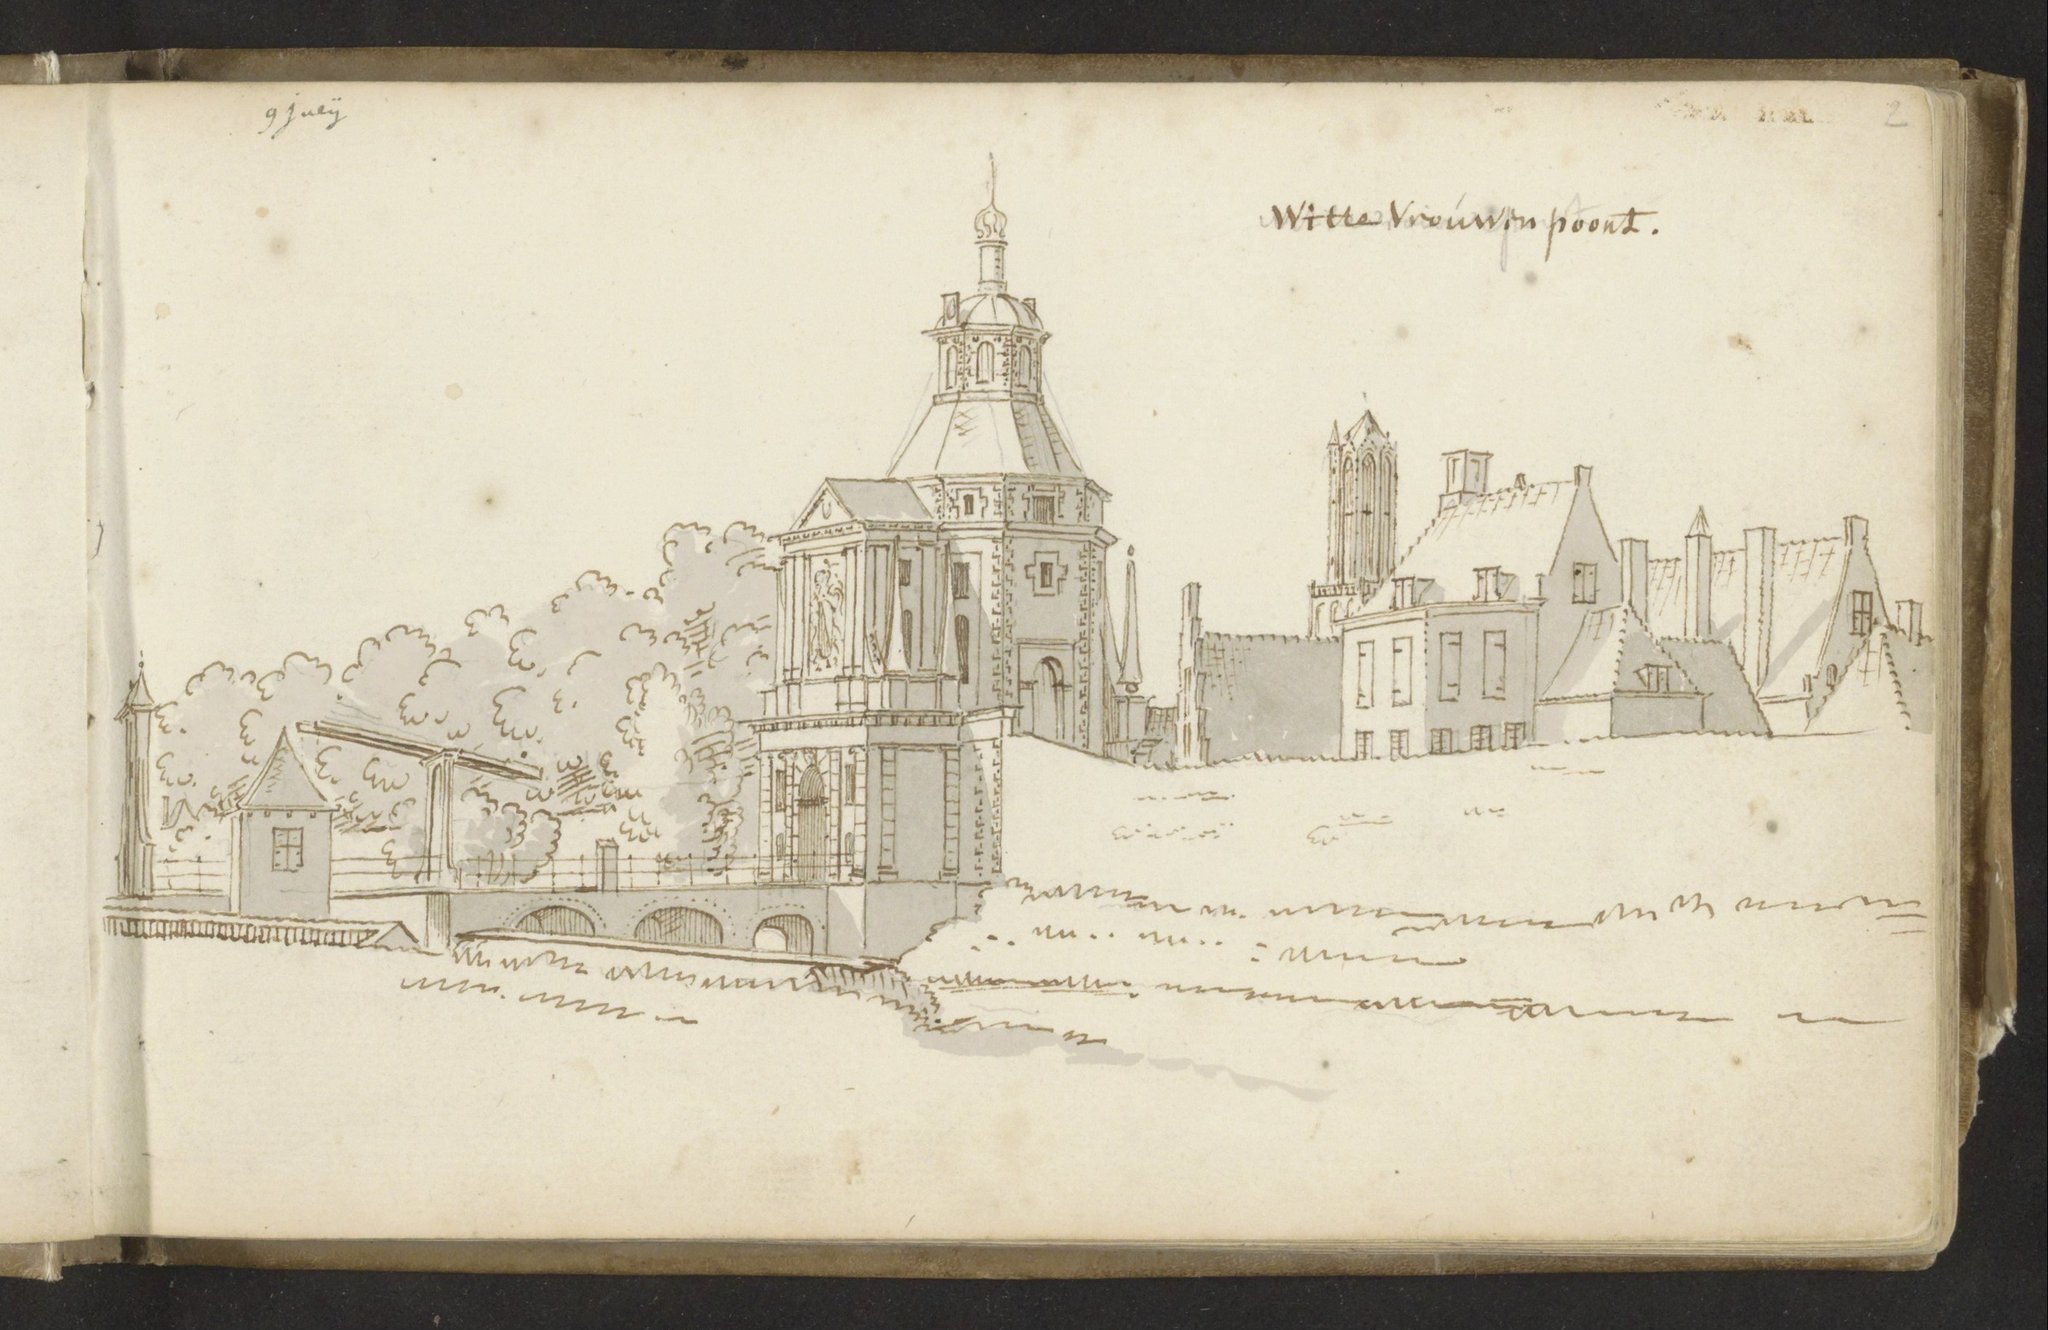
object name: drawing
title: Wittevrouwenpoort te Utrecht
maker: abraham de haen (ii)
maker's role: draughtsman, print maker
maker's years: 1707-1748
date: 1731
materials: ink, paper, pencil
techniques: brush, pen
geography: utrecht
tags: city-gate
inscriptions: date and inscription: ‘9 julij/ WitteVrouwen poort.’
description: Wittevrouwenpoort te Utrecht gezien van buiten de stadsmuur met links de ophaalbrug en rechts boven de daken van huizen de toren van de Domkerk. Blad 2 recto uit een schetsboek met 69 bladen.